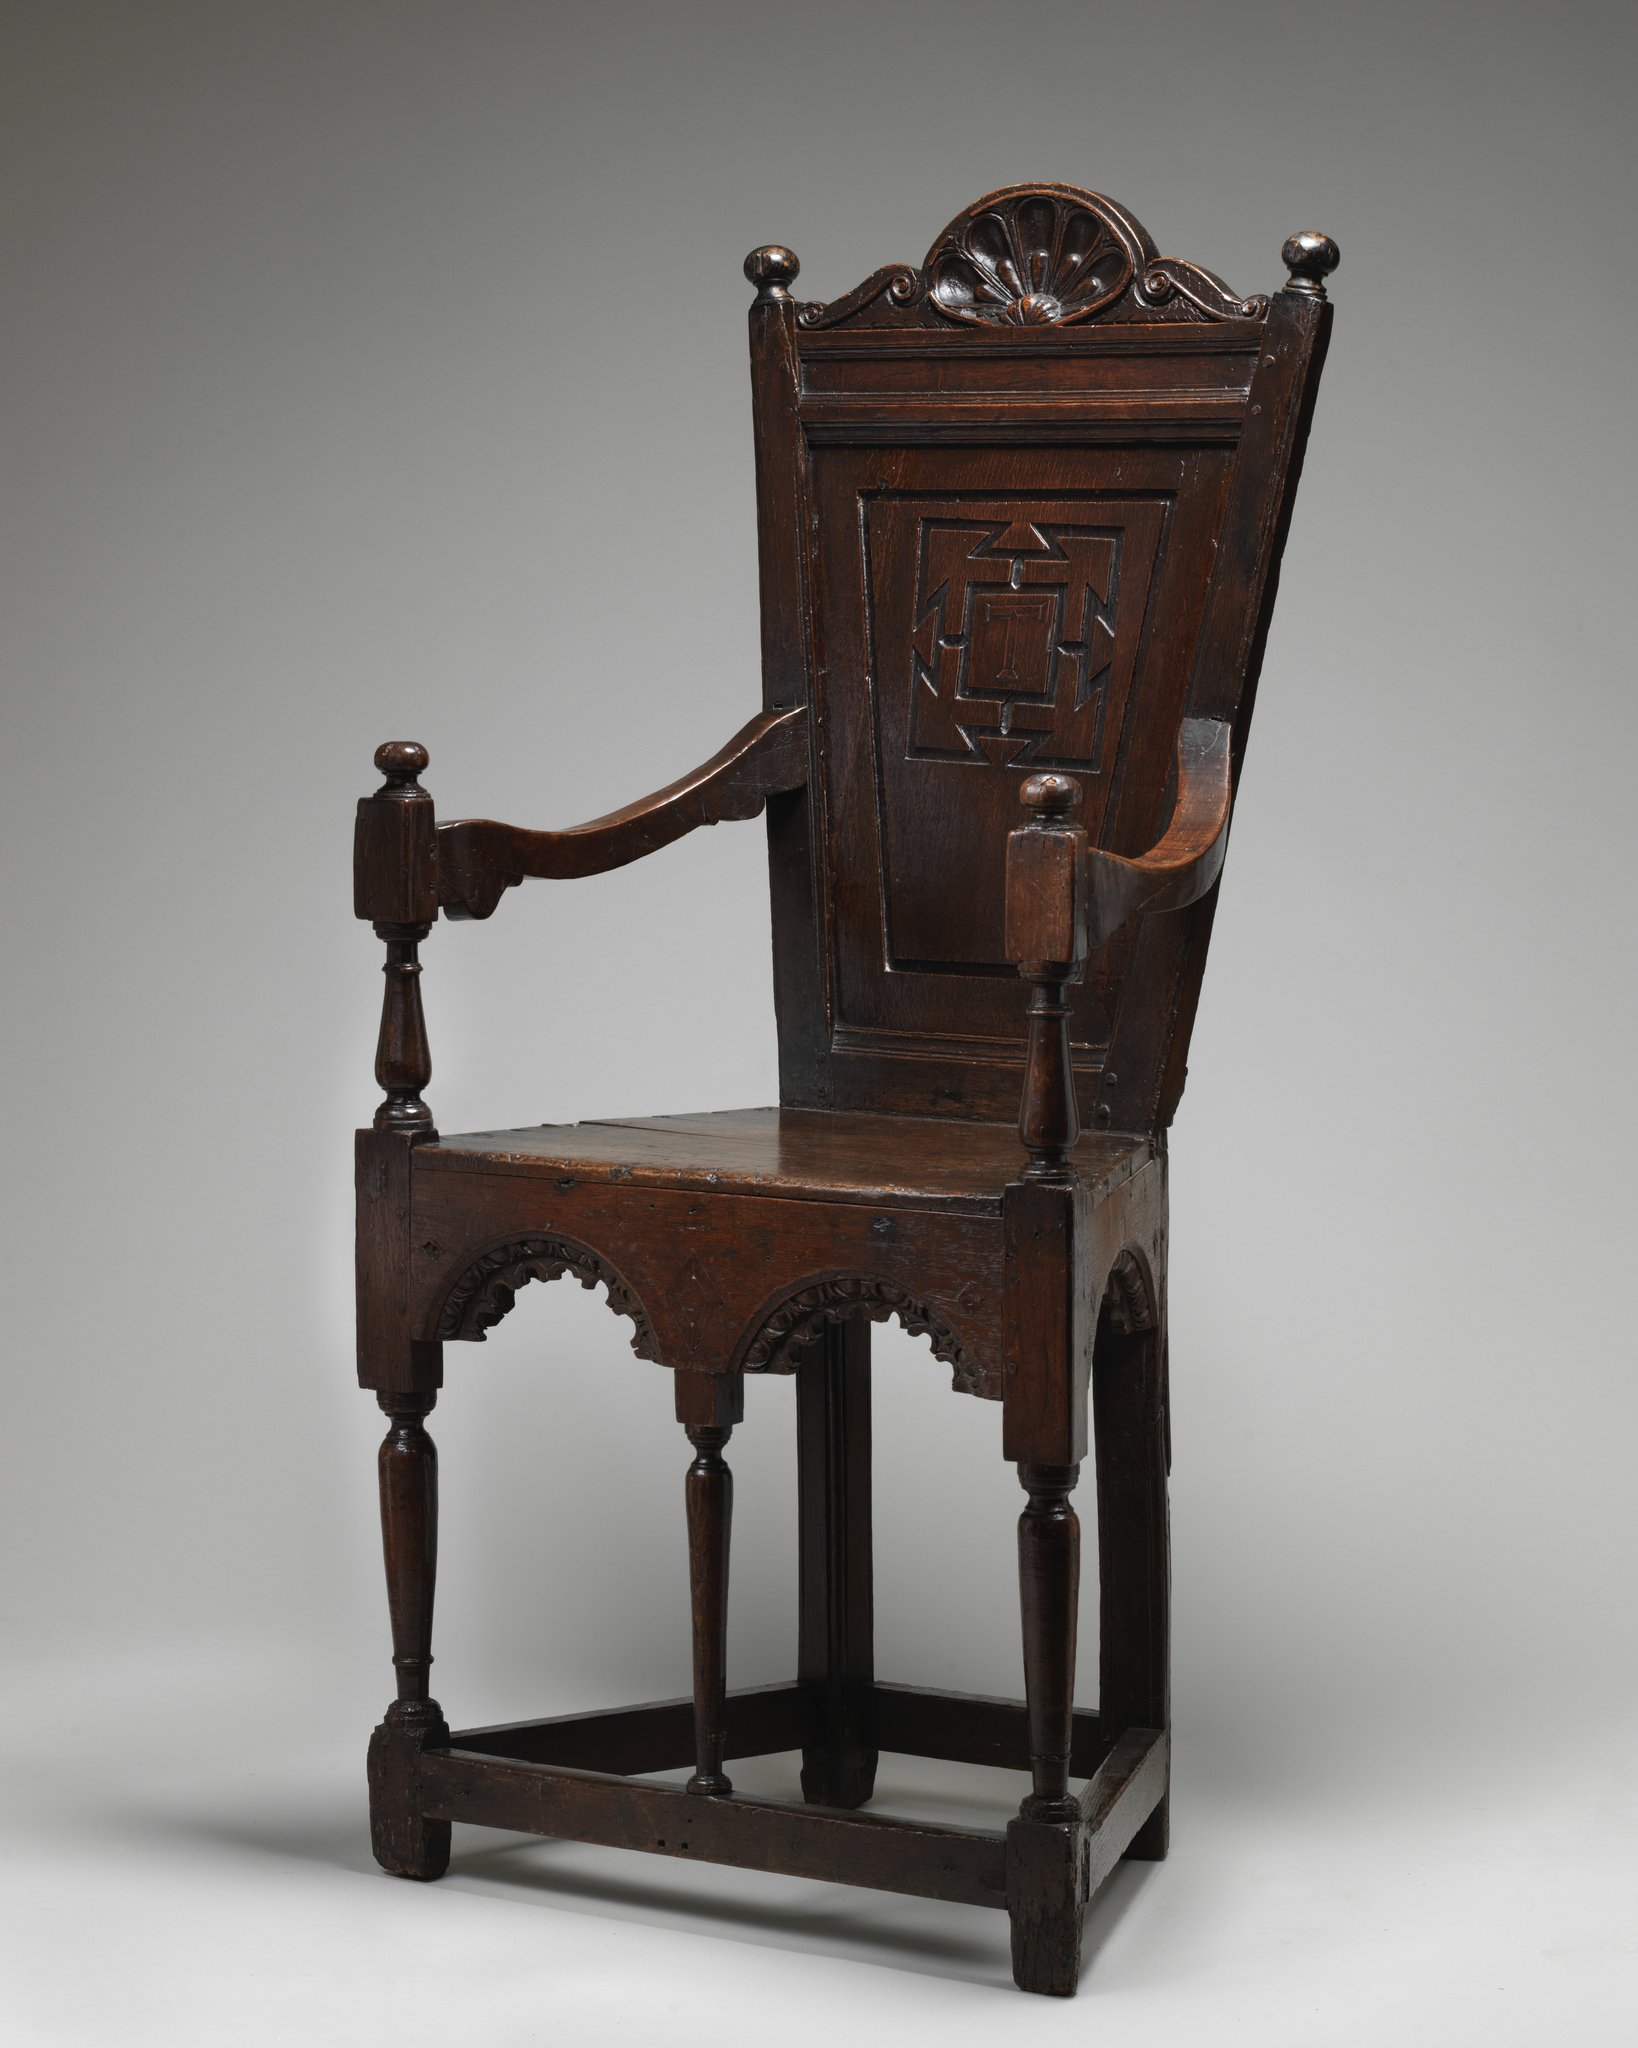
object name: armchair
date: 1600-1625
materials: wood